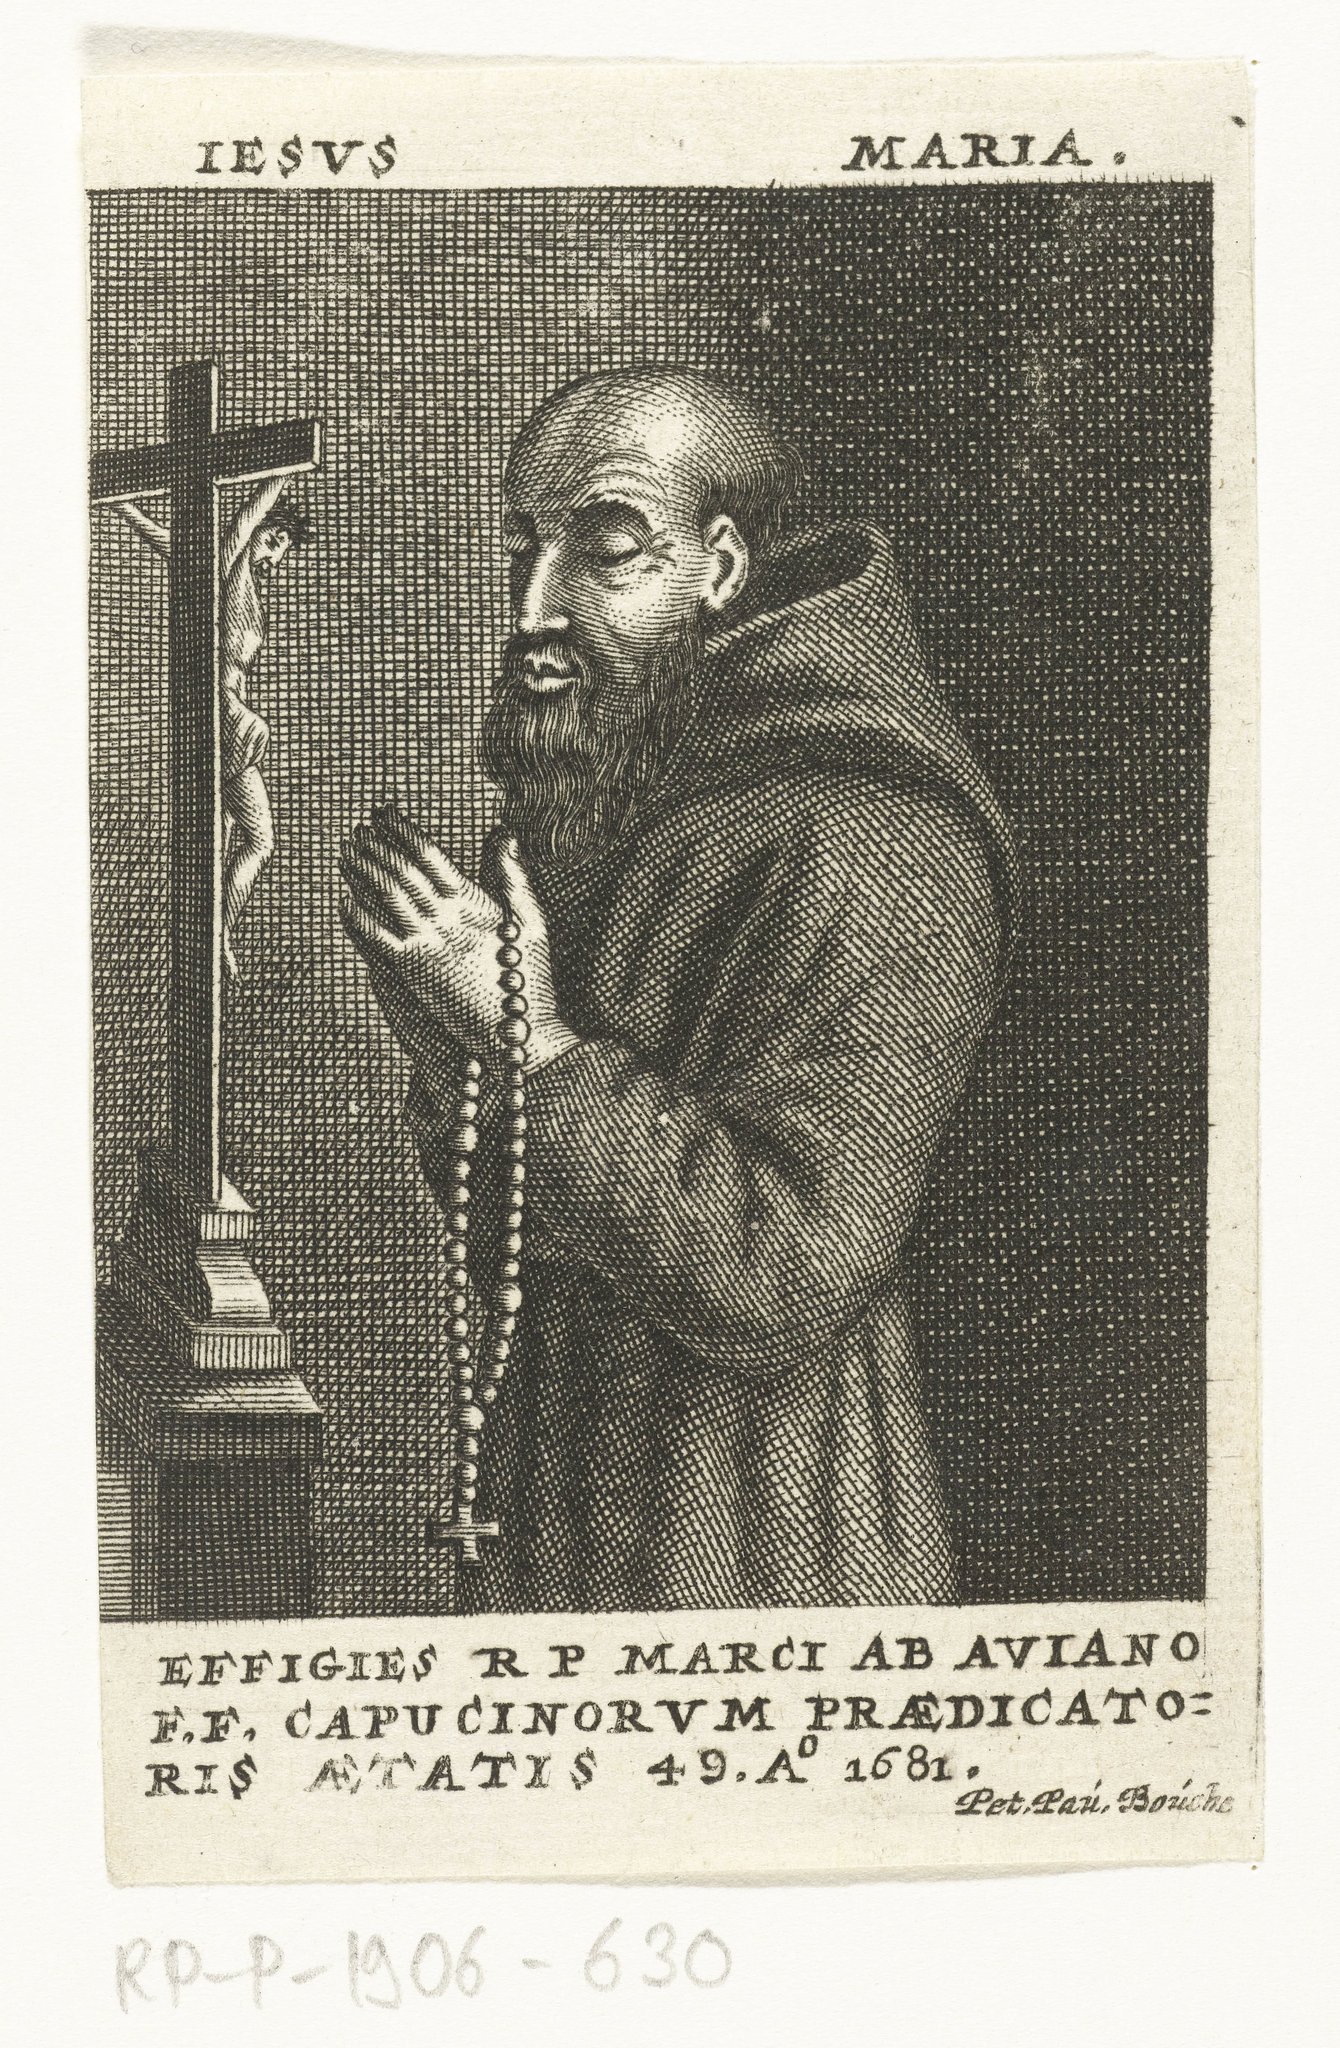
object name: print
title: Marcus ab Aviano biddend voor een crucifix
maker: peter paul bouché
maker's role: print maker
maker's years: 1646-1713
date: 1681-1713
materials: paper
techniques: engraving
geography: antwerp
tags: one person praying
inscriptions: collector's mark: Lugt 2228